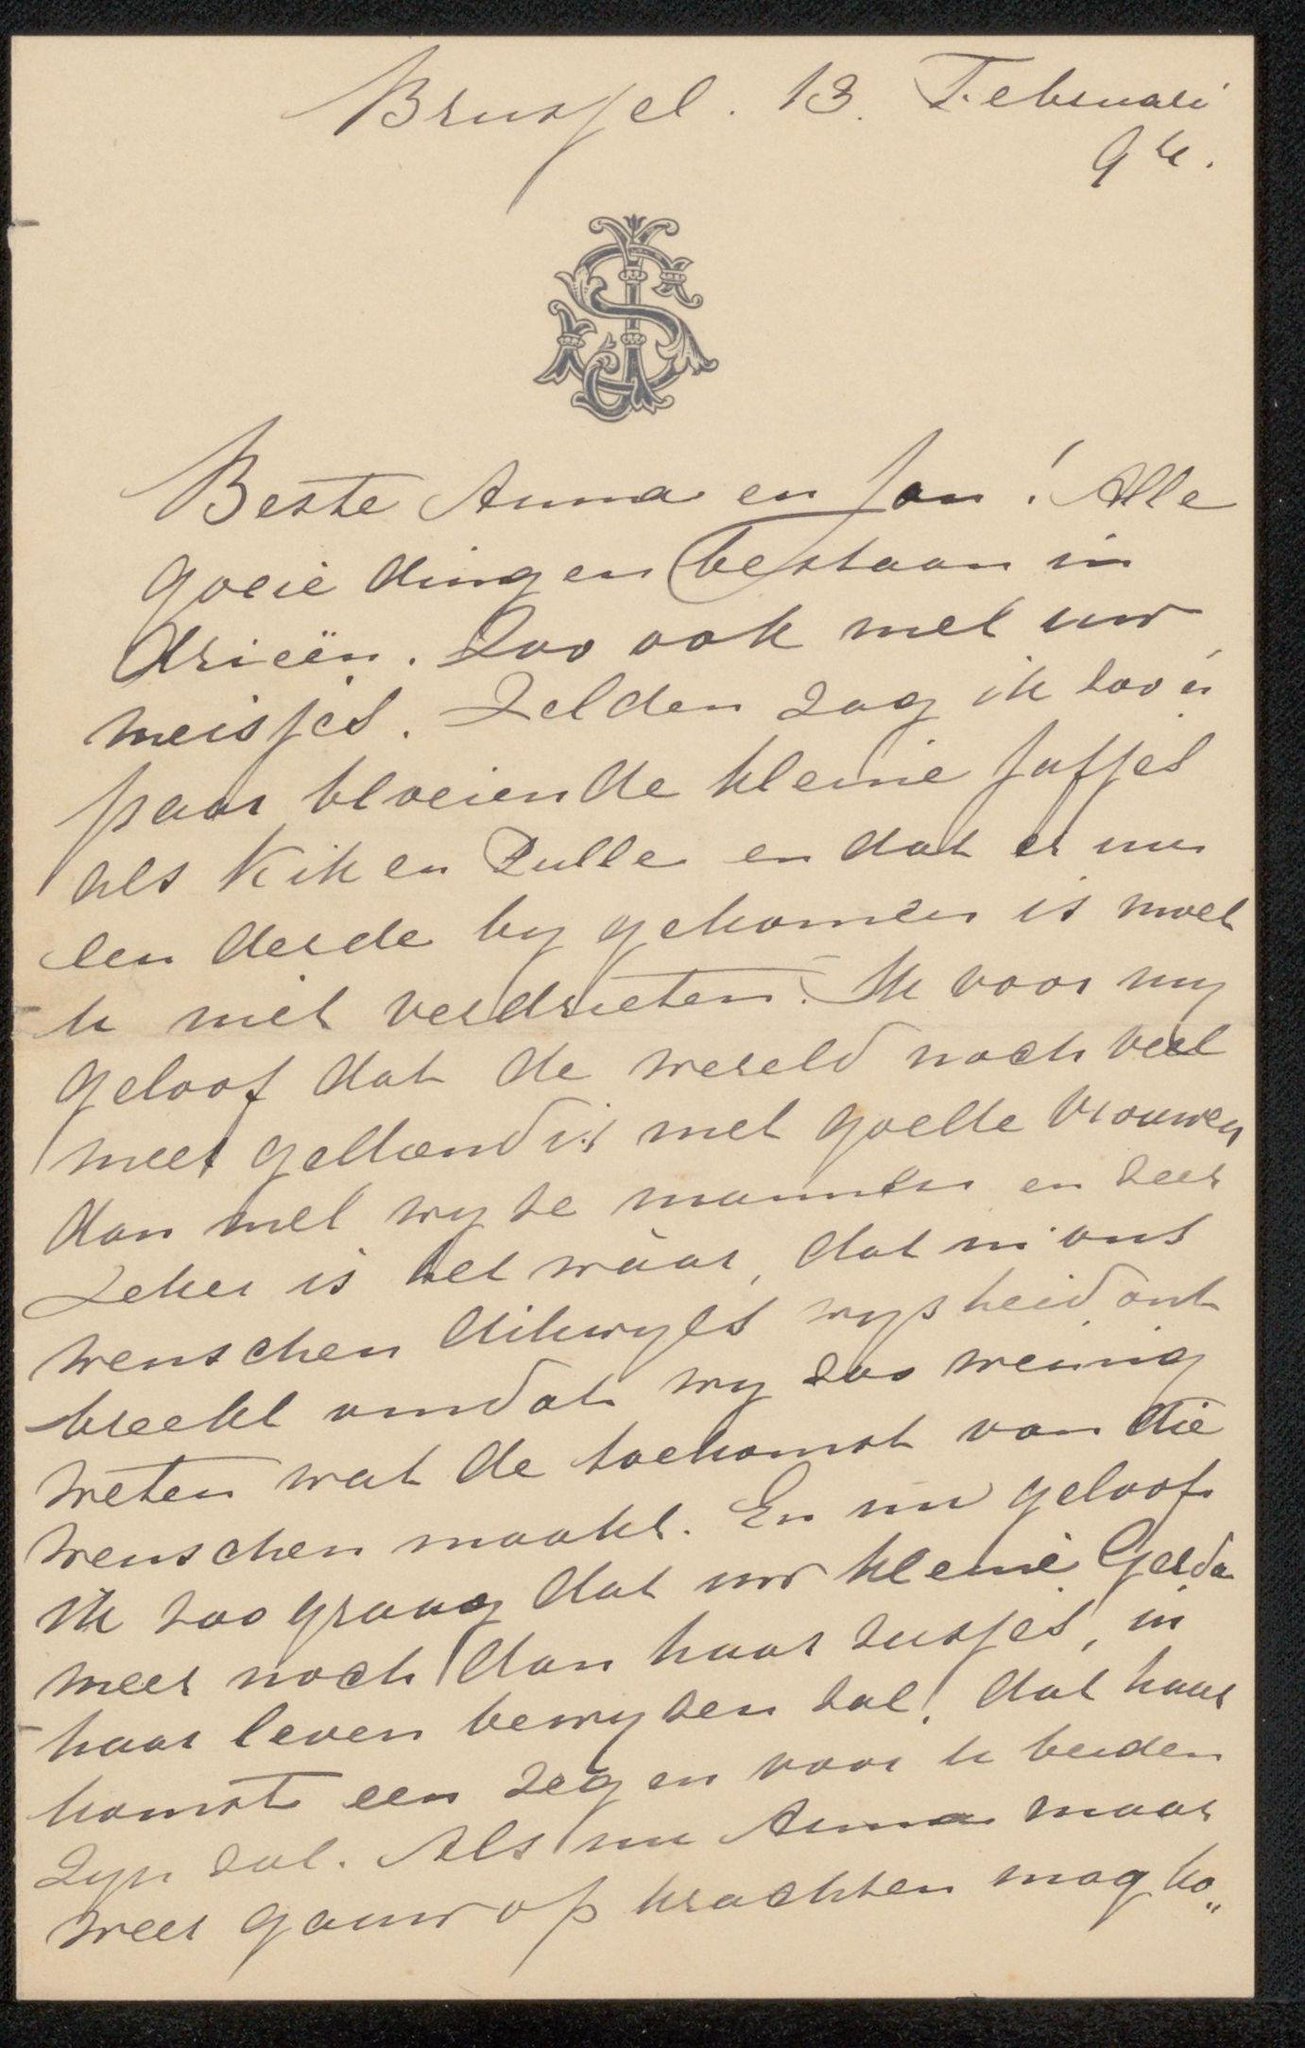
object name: letter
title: Brief aan Anna Dorothea Dirks en Jan Veth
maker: jacoba cornelia jolles-singels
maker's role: schrijver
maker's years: 1847-1901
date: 1894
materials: ink, paper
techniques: pen, writing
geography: brussels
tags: dordrecht, amsterdam, painter, print maker, draughtsman, designer, jan veth, mayor, gijsbert van tienhoven, artist, anna dorothea dirks, andré jolles, family life, travelling; tourism, diseases, brussels, rome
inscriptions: monogram: ‘JS’, collector's mark: ‘RPK’